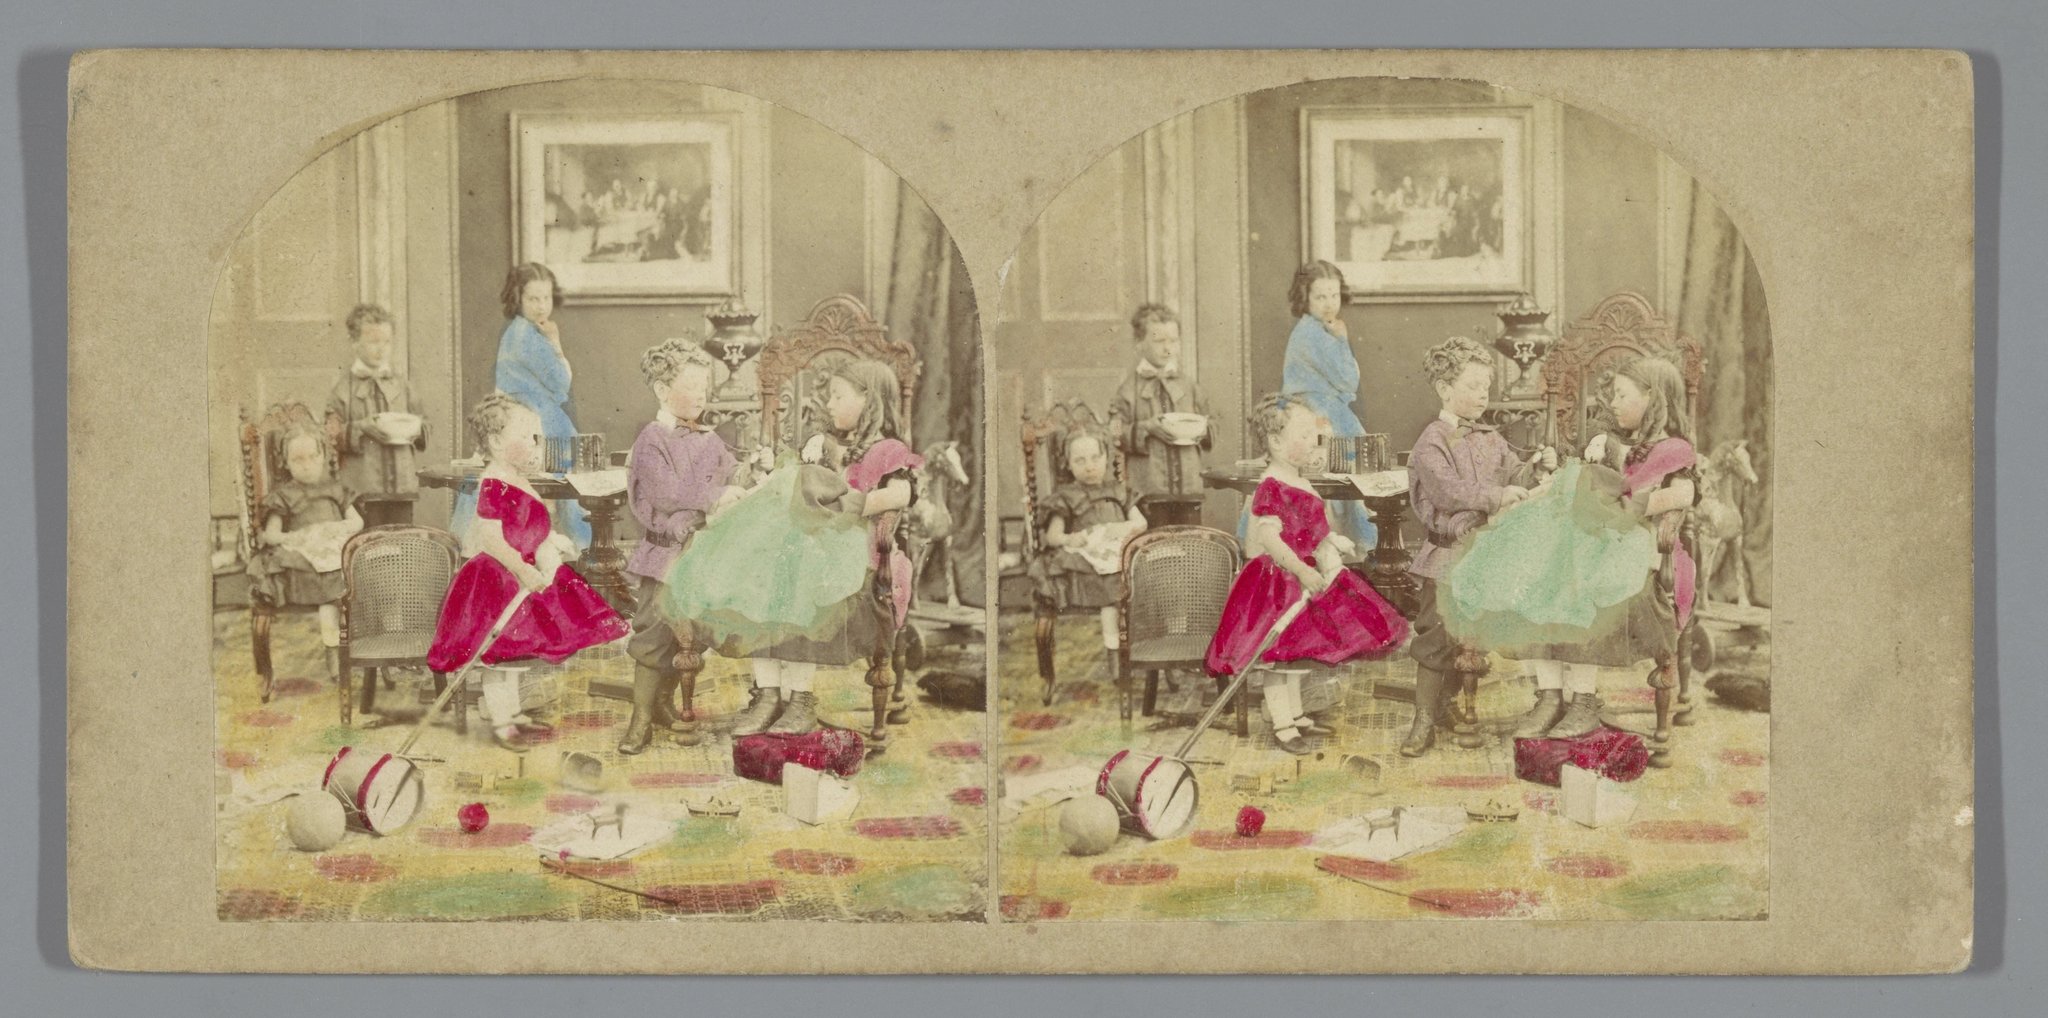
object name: stereograph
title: The Sick Doll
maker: Anonymous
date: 1852-1863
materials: cardboard, paper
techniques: albumen print, hand coloring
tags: children's games and plays, living-room, parlour, sitting-room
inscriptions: copyright notice: ‘Copyright.’, inscription: ‘P’